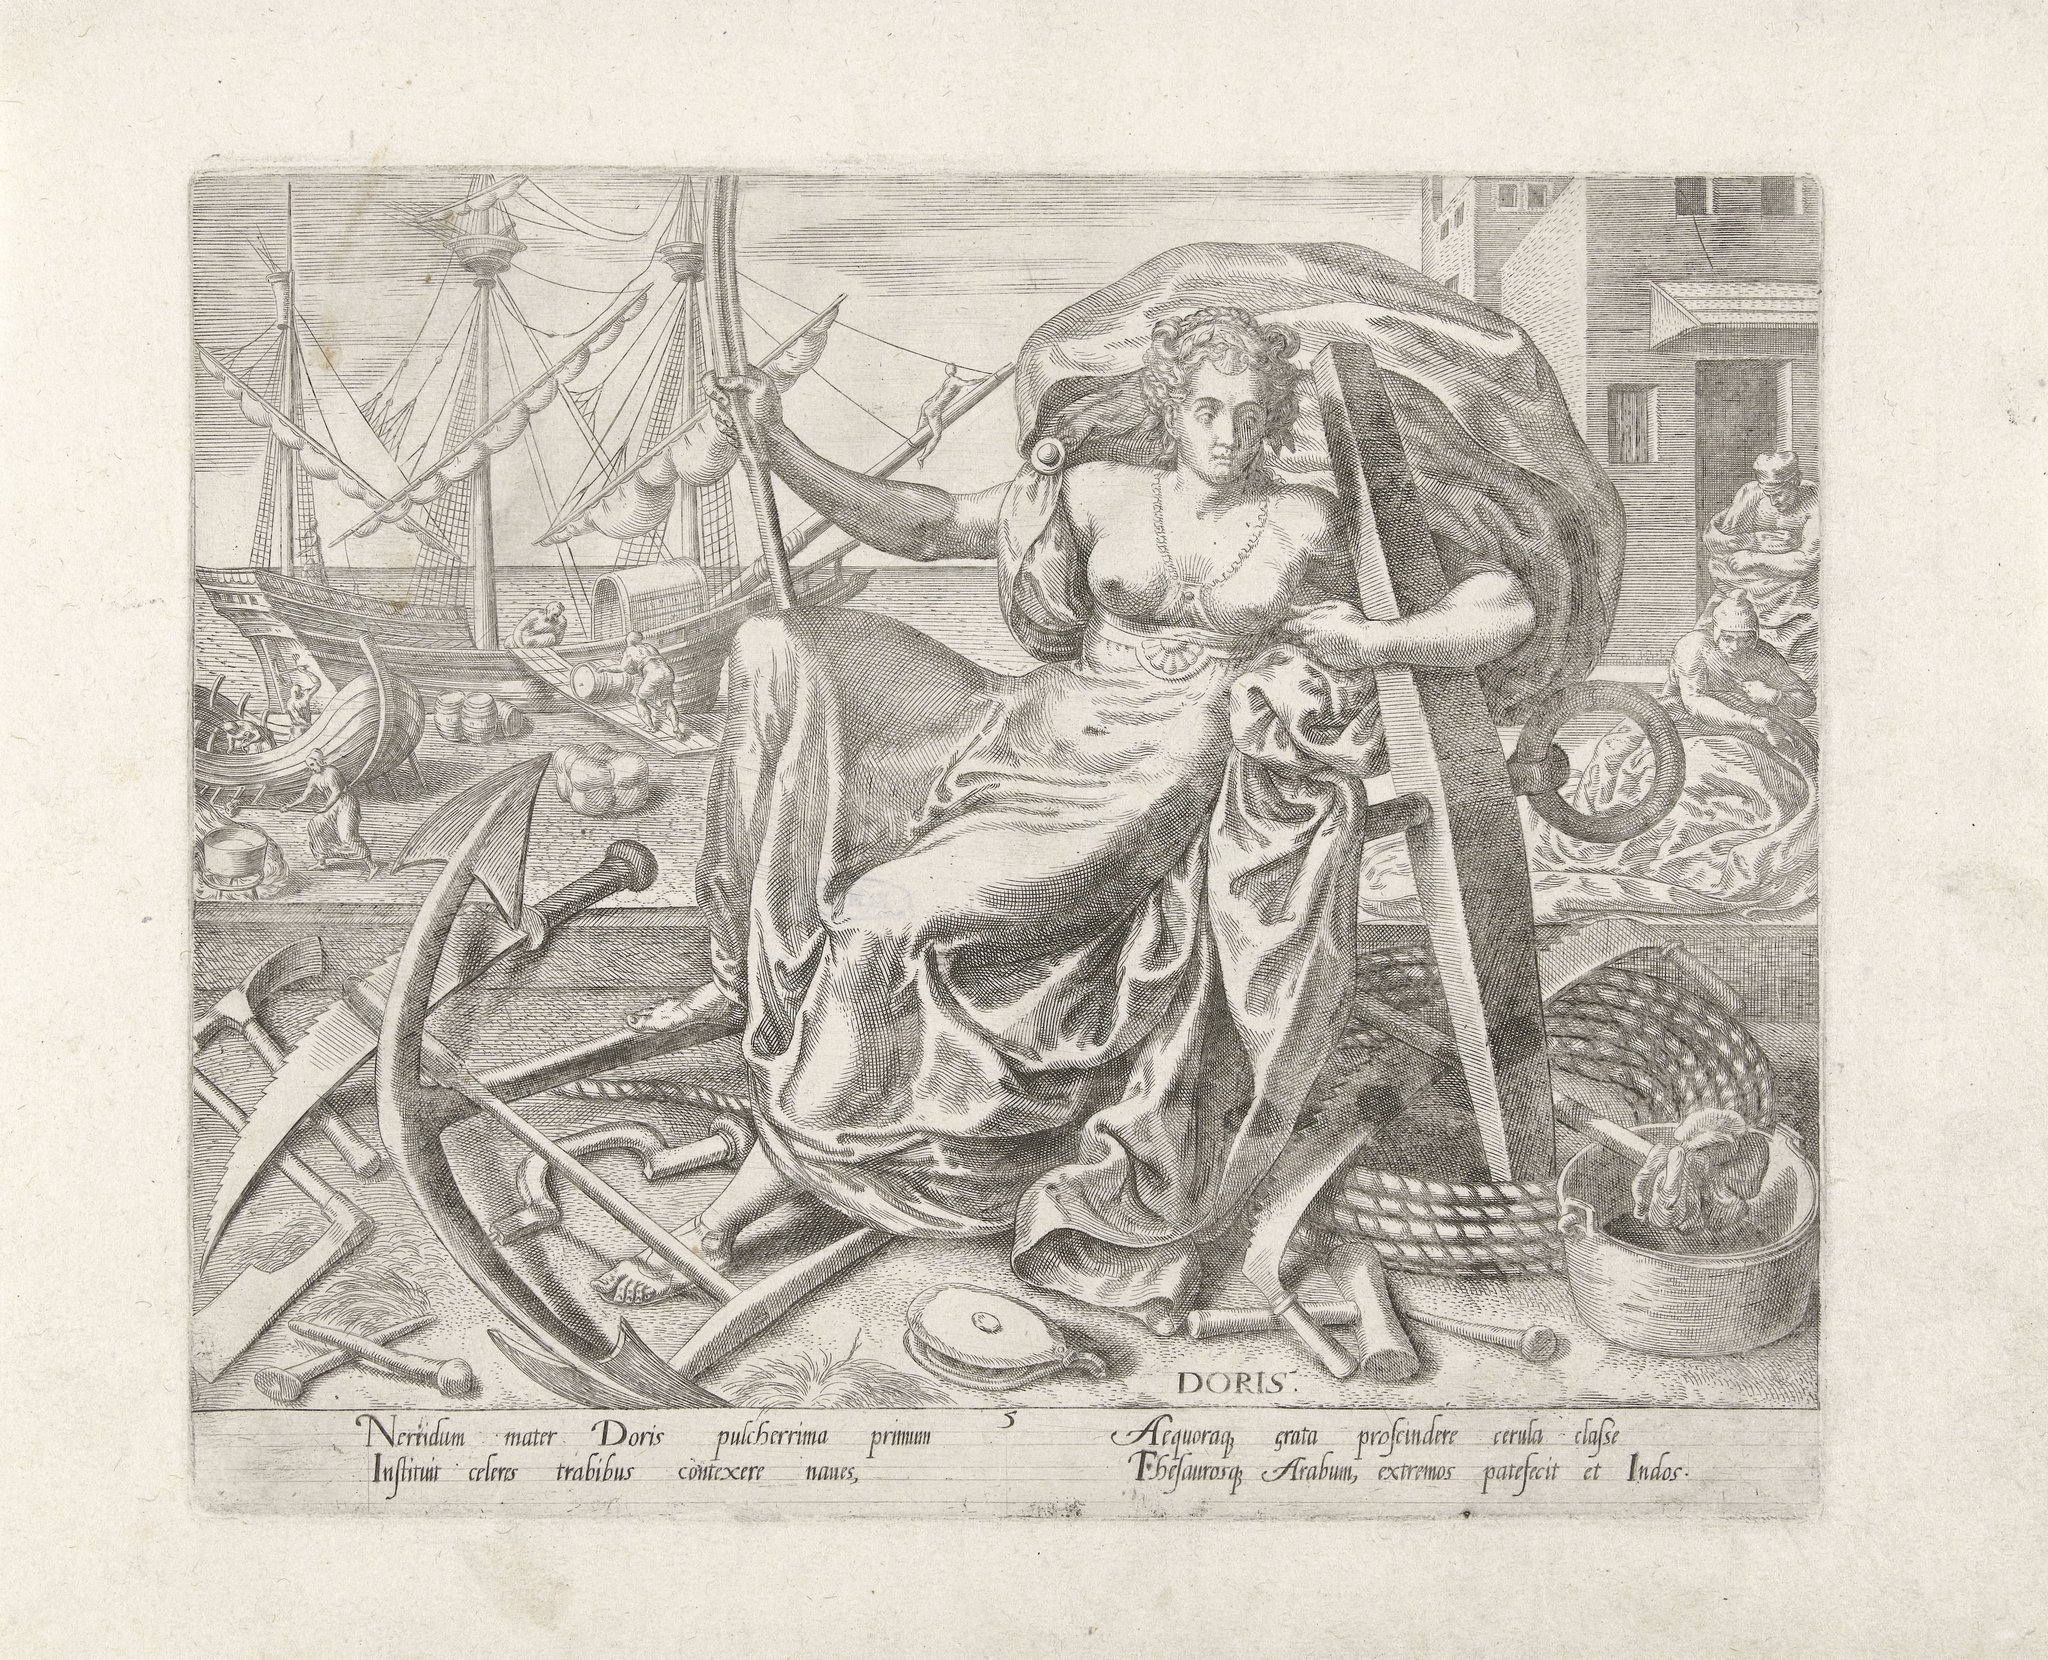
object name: print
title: Doris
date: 1574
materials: paper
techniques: engraving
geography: antwerp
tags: crafts and industries, doris, wife of nereus, 'navigatione' (ripa), 'artes mechanicae' (lanificium, armatura, navigatio, agricultura, venatio, medicina, theatrica), mending of fishing nets, ships (in general) (+ loading)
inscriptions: collector's mark: Lugt 2228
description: De Romeinse godheid Doris als personificatie van de navigatie en zeehandel. Zij zit op de voorgrond op een groot anker en is omgeven door allerlei gereedschap, verwijzend naar de zeevaart. Achter haar, rechts, zitten twee lieden netten te boeten. Linksachter wordt een houten boot gebouwd en wordt een zeilschip van lading voorzien.De prent heeft een Latijns onderschrift en maakt deel uit van een prentenreeks over de menselijke bedrijvigheden.